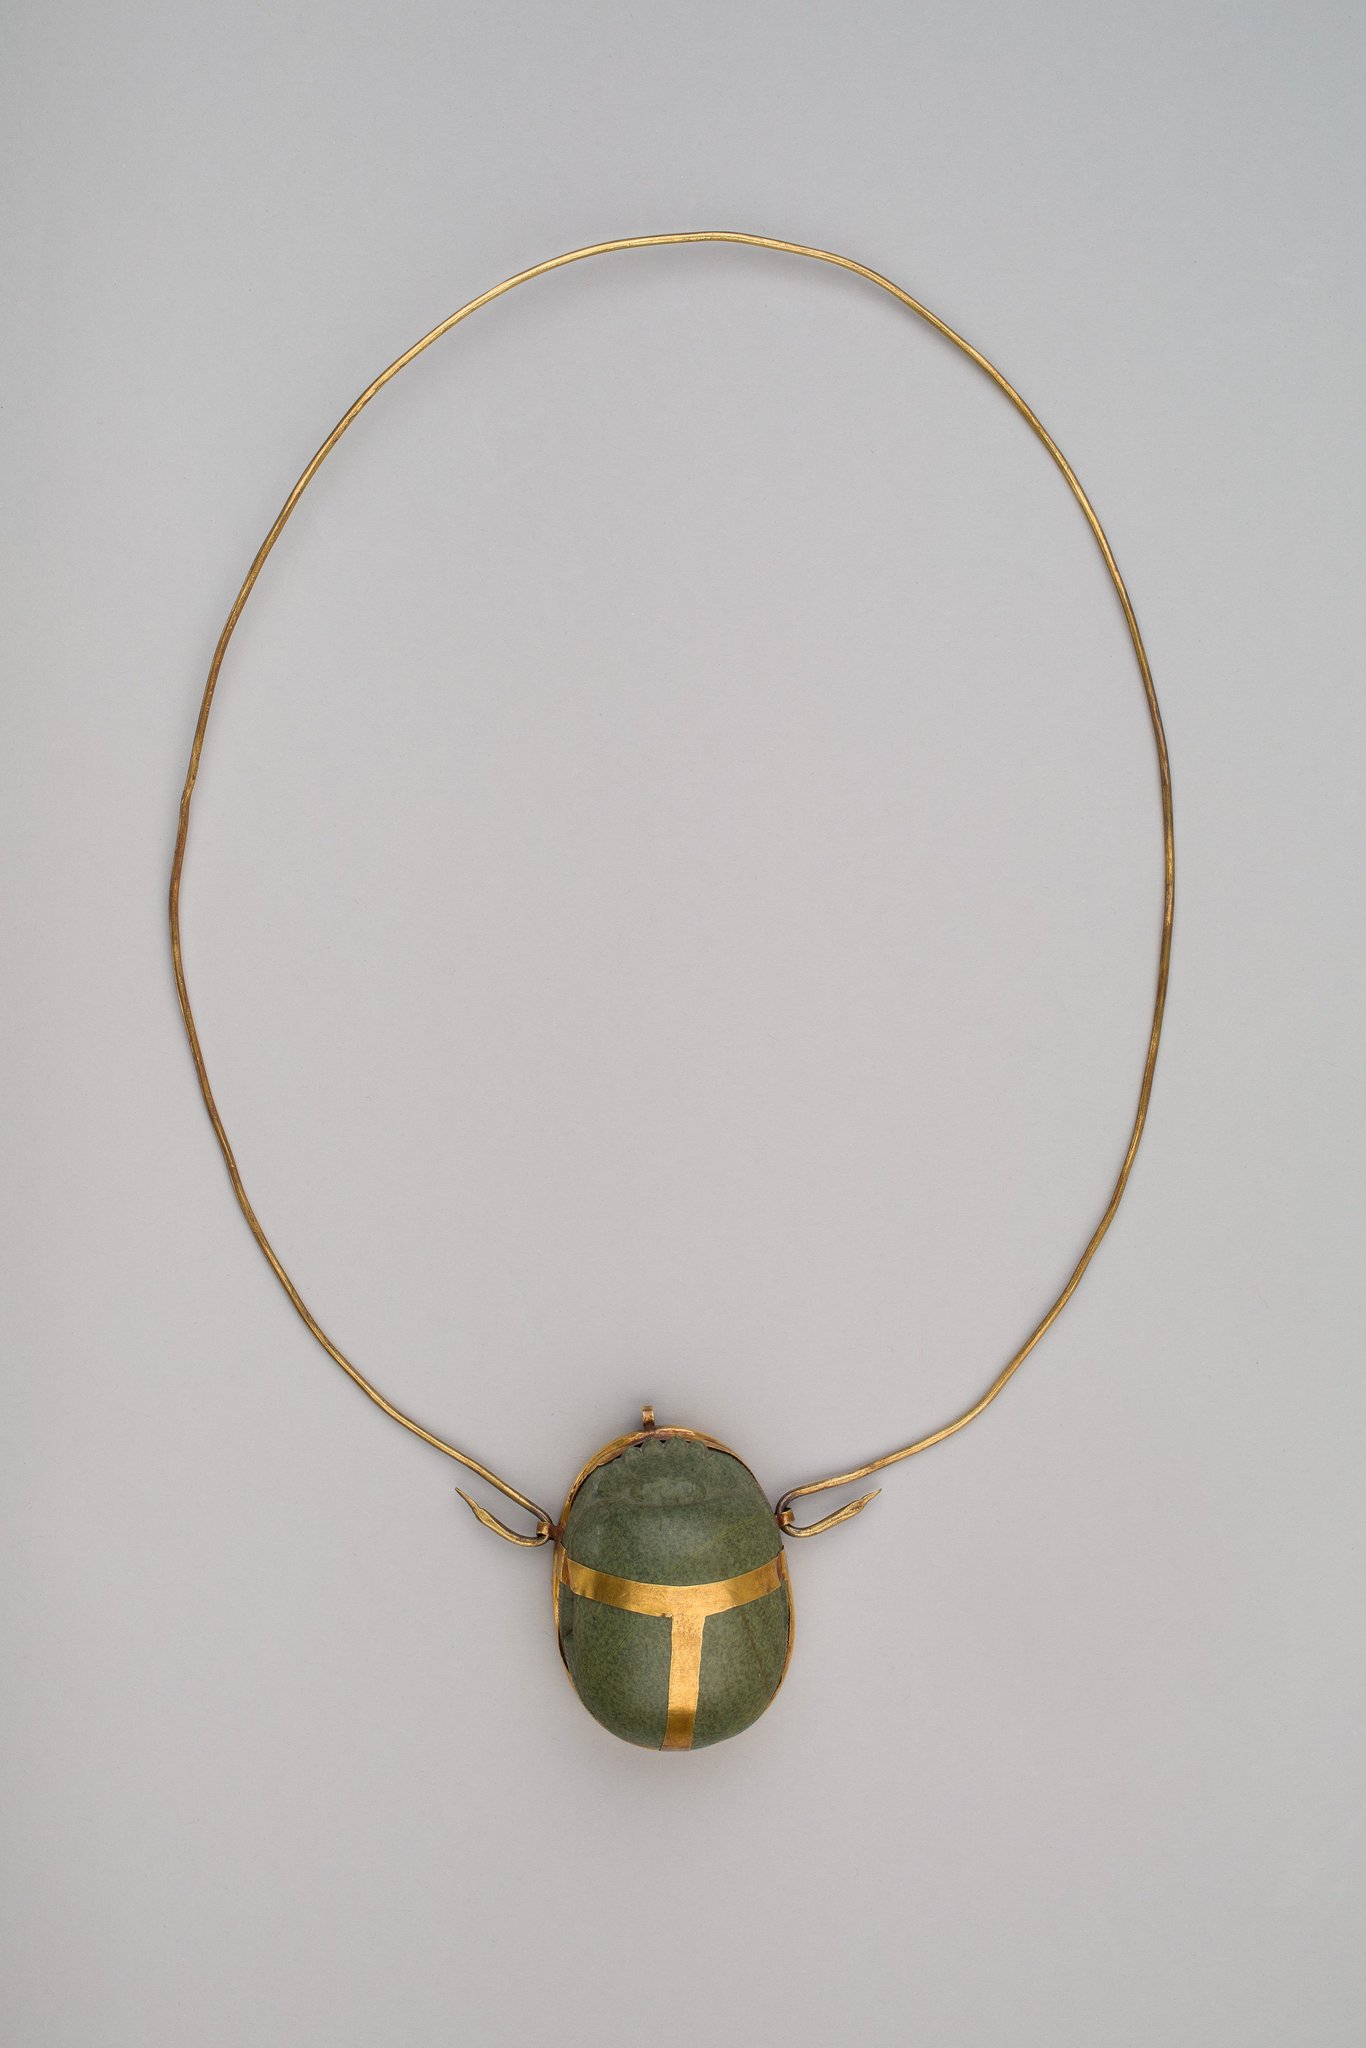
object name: heart scarab, maruta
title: Heart Scarab of Maruta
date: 1479-1425 BCE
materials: gold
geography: egypt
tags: scarabs